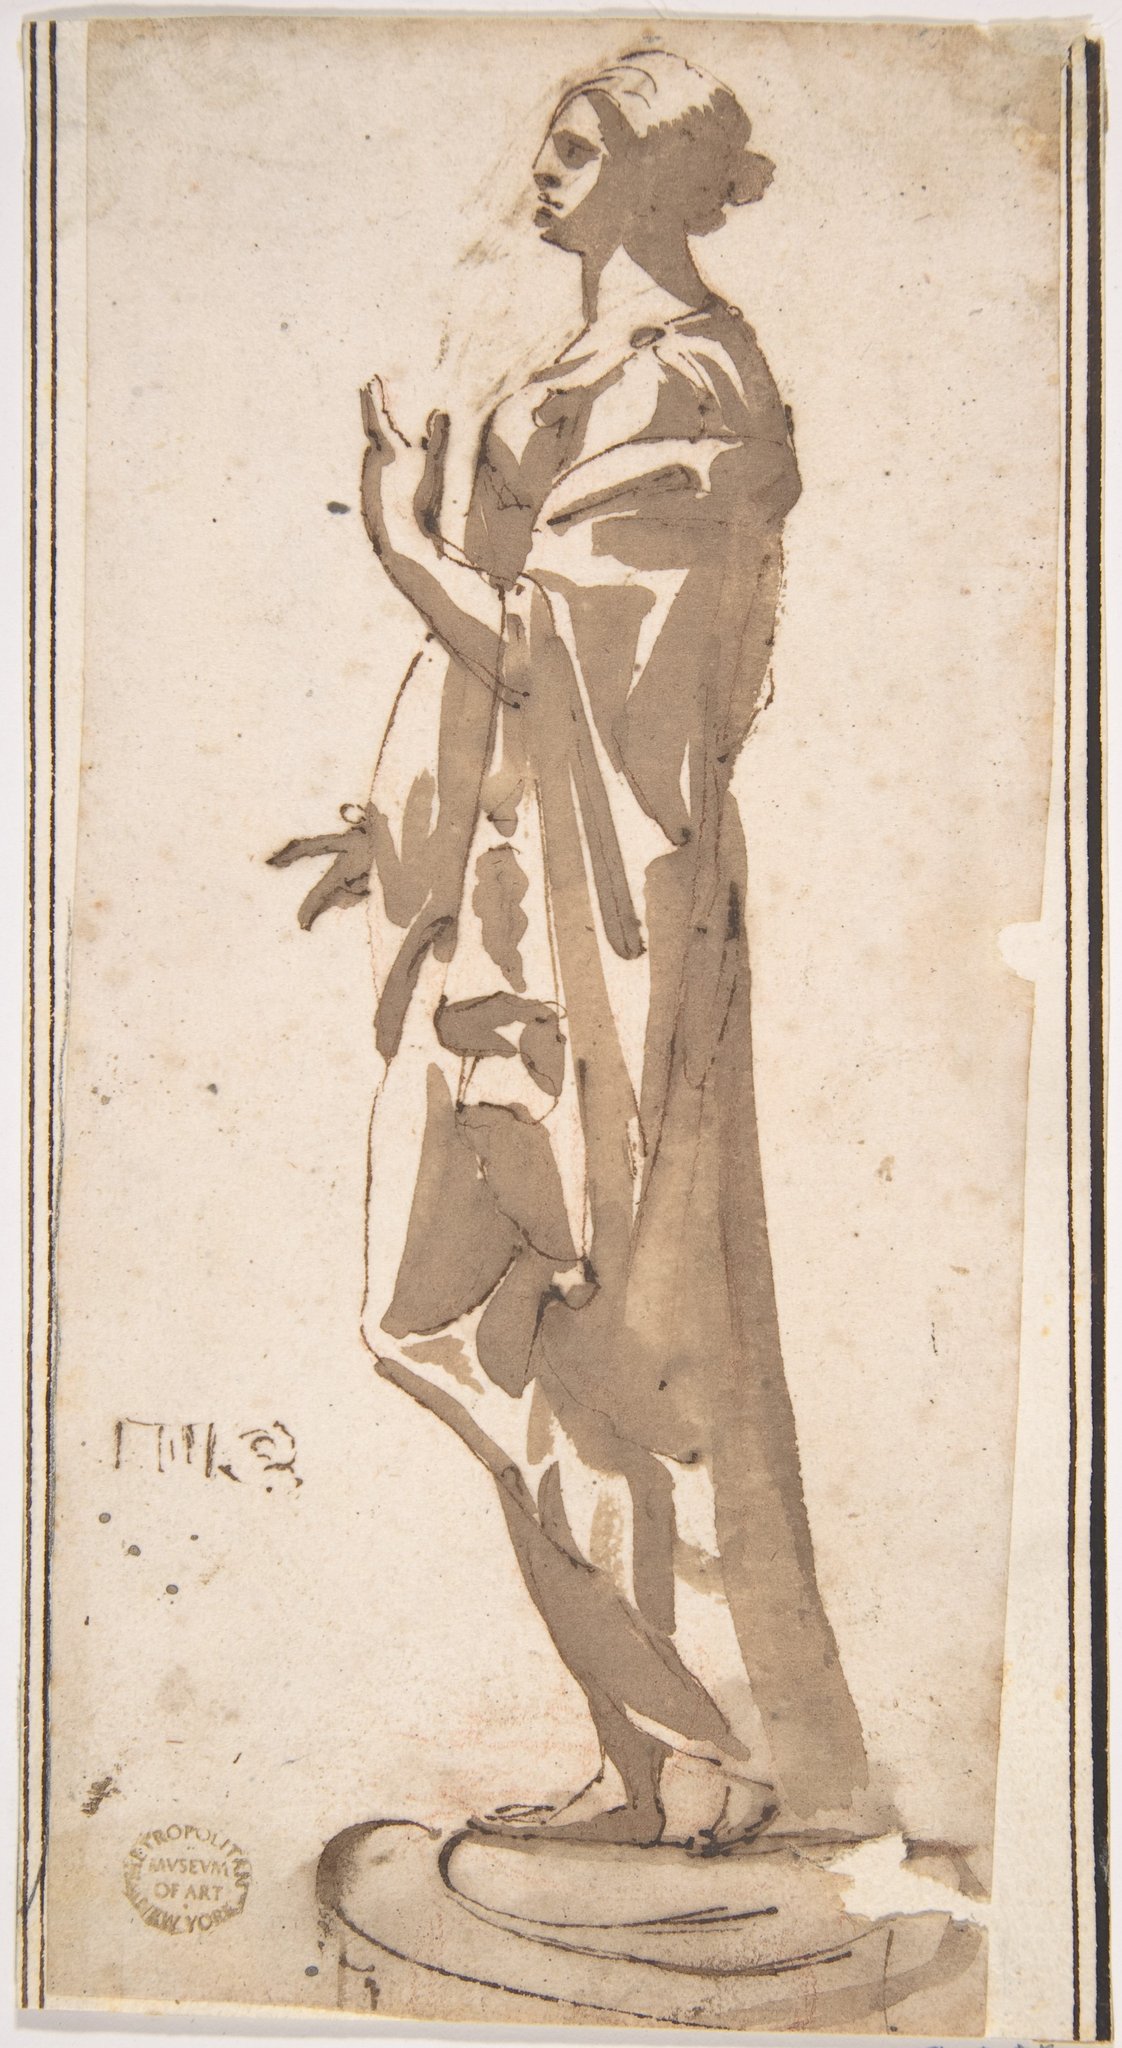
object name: drawing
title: Statue of a Draped Female Figure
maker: anonymous, italian, 17th century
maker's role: artist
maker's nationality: italian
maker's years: 1600-1700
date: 1601-1700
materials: ink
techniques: brush, pen, wash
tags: women